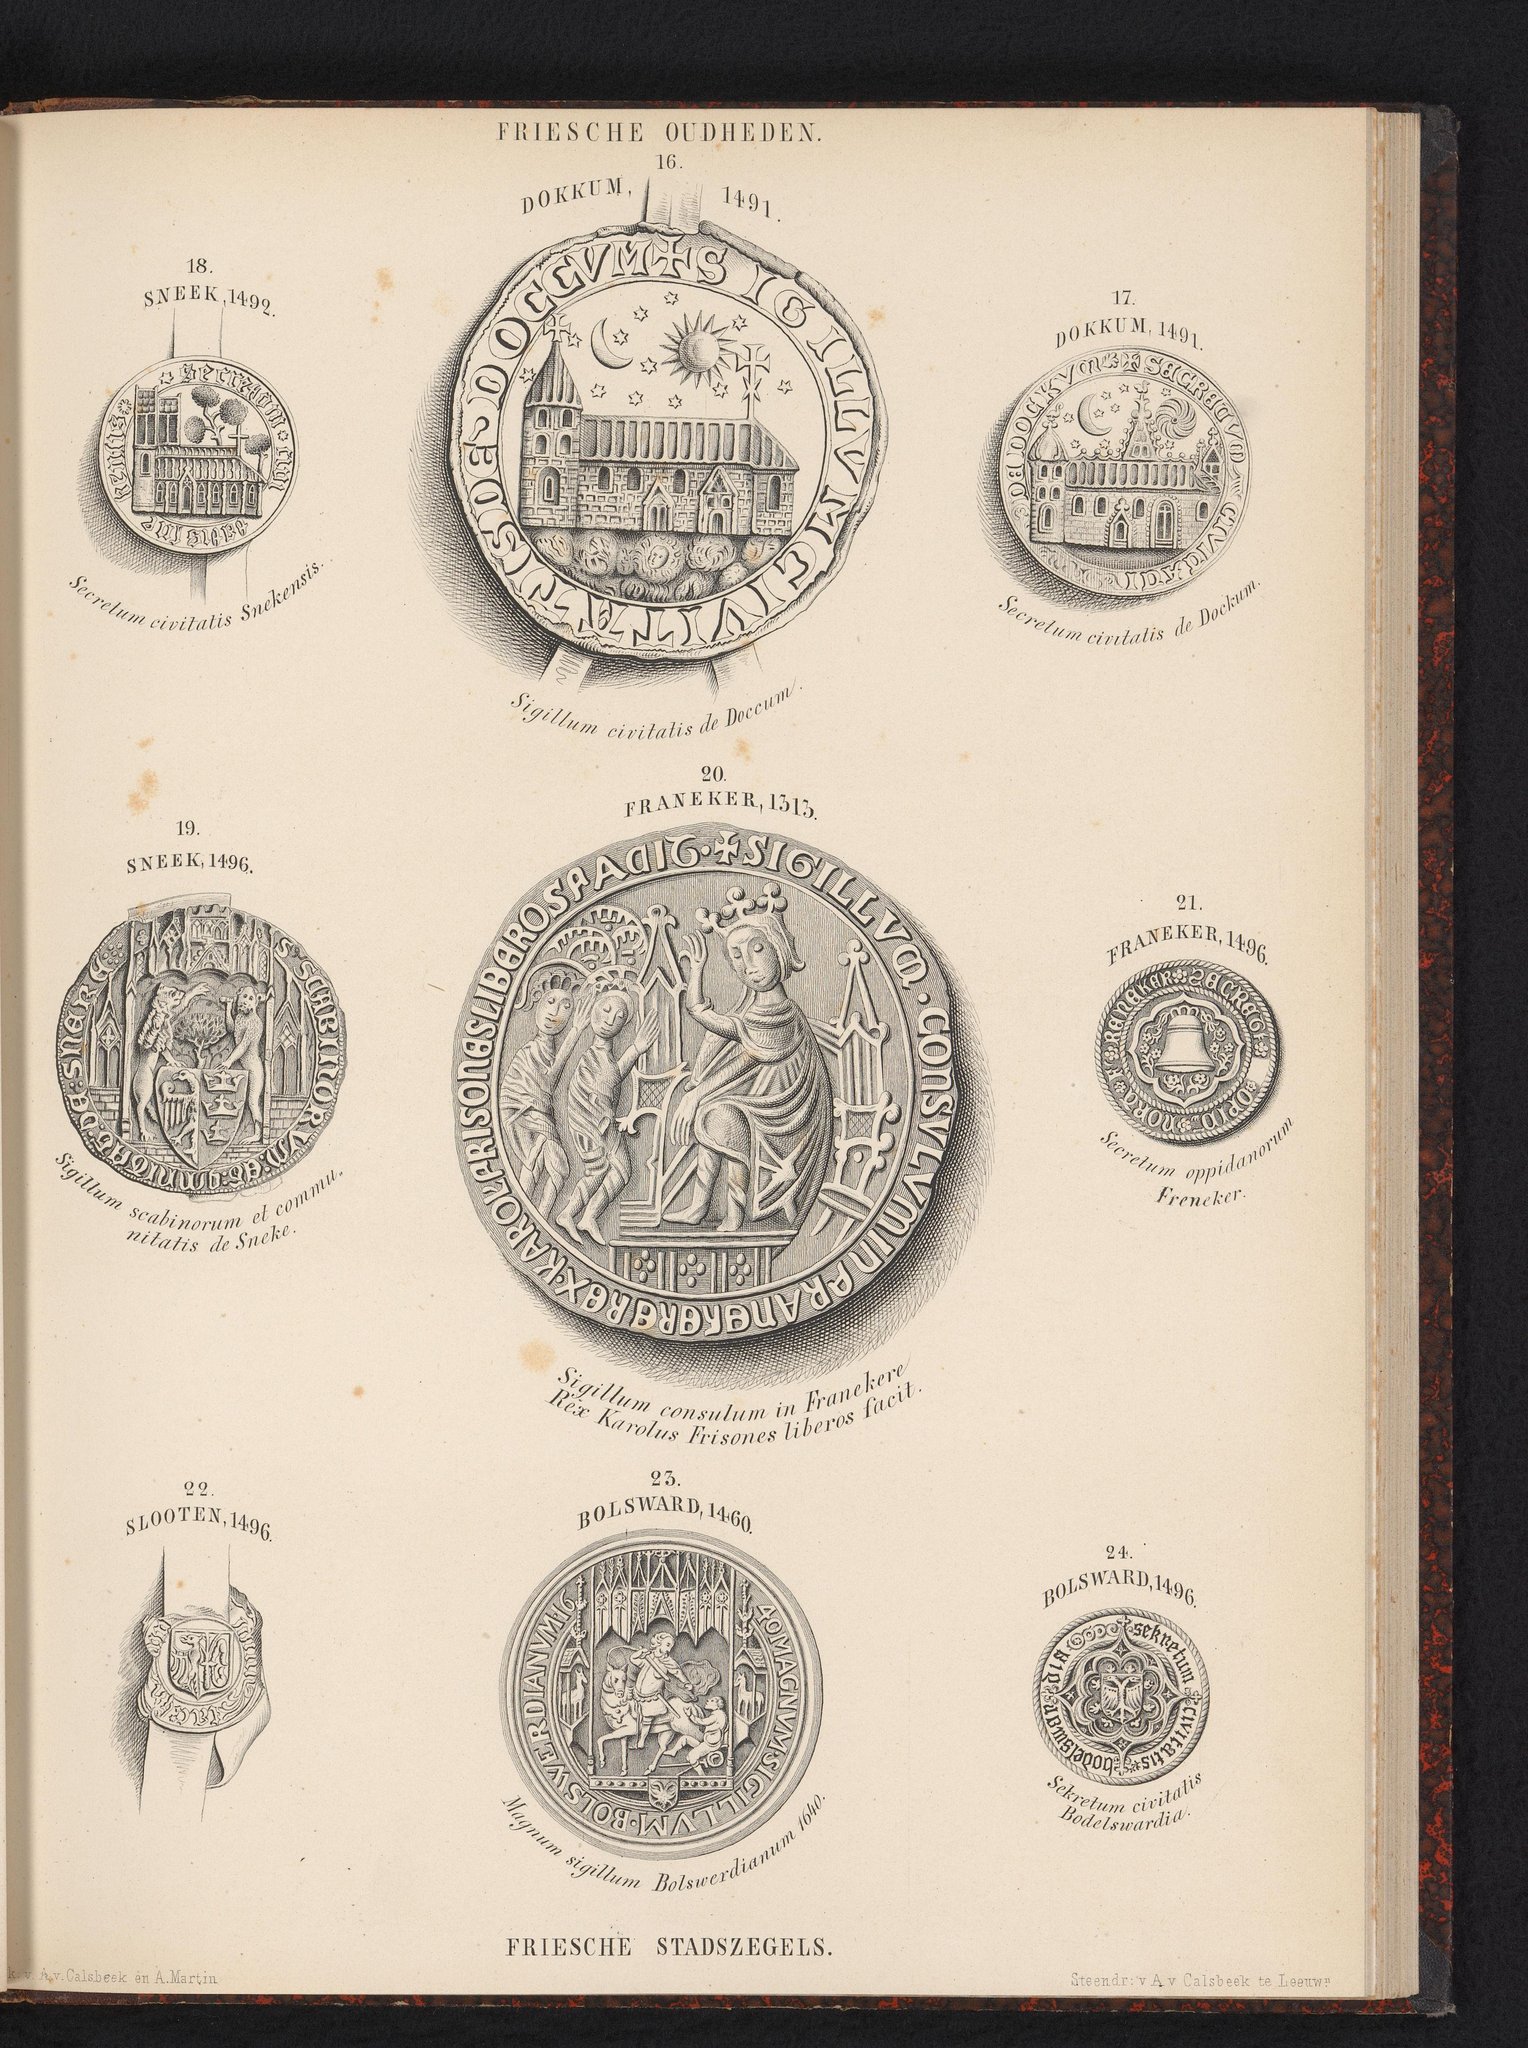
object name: historical object representation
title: Oude Friese stadszegels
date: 1870-1875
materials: paper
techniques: lithograph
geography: leeuwarden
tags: seal, stamp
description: Illustratie in: Friesche Oudheden. Afbeeldingen van merkwaardige voorwerpen van Wetenschap en Kunst, gevonden in de archieven, kerken, kasteelen, terpen enz. van Friesland, Leeuwarden 1875. Niet in Frederik Muller; door het RPK toegevoegd nummer.